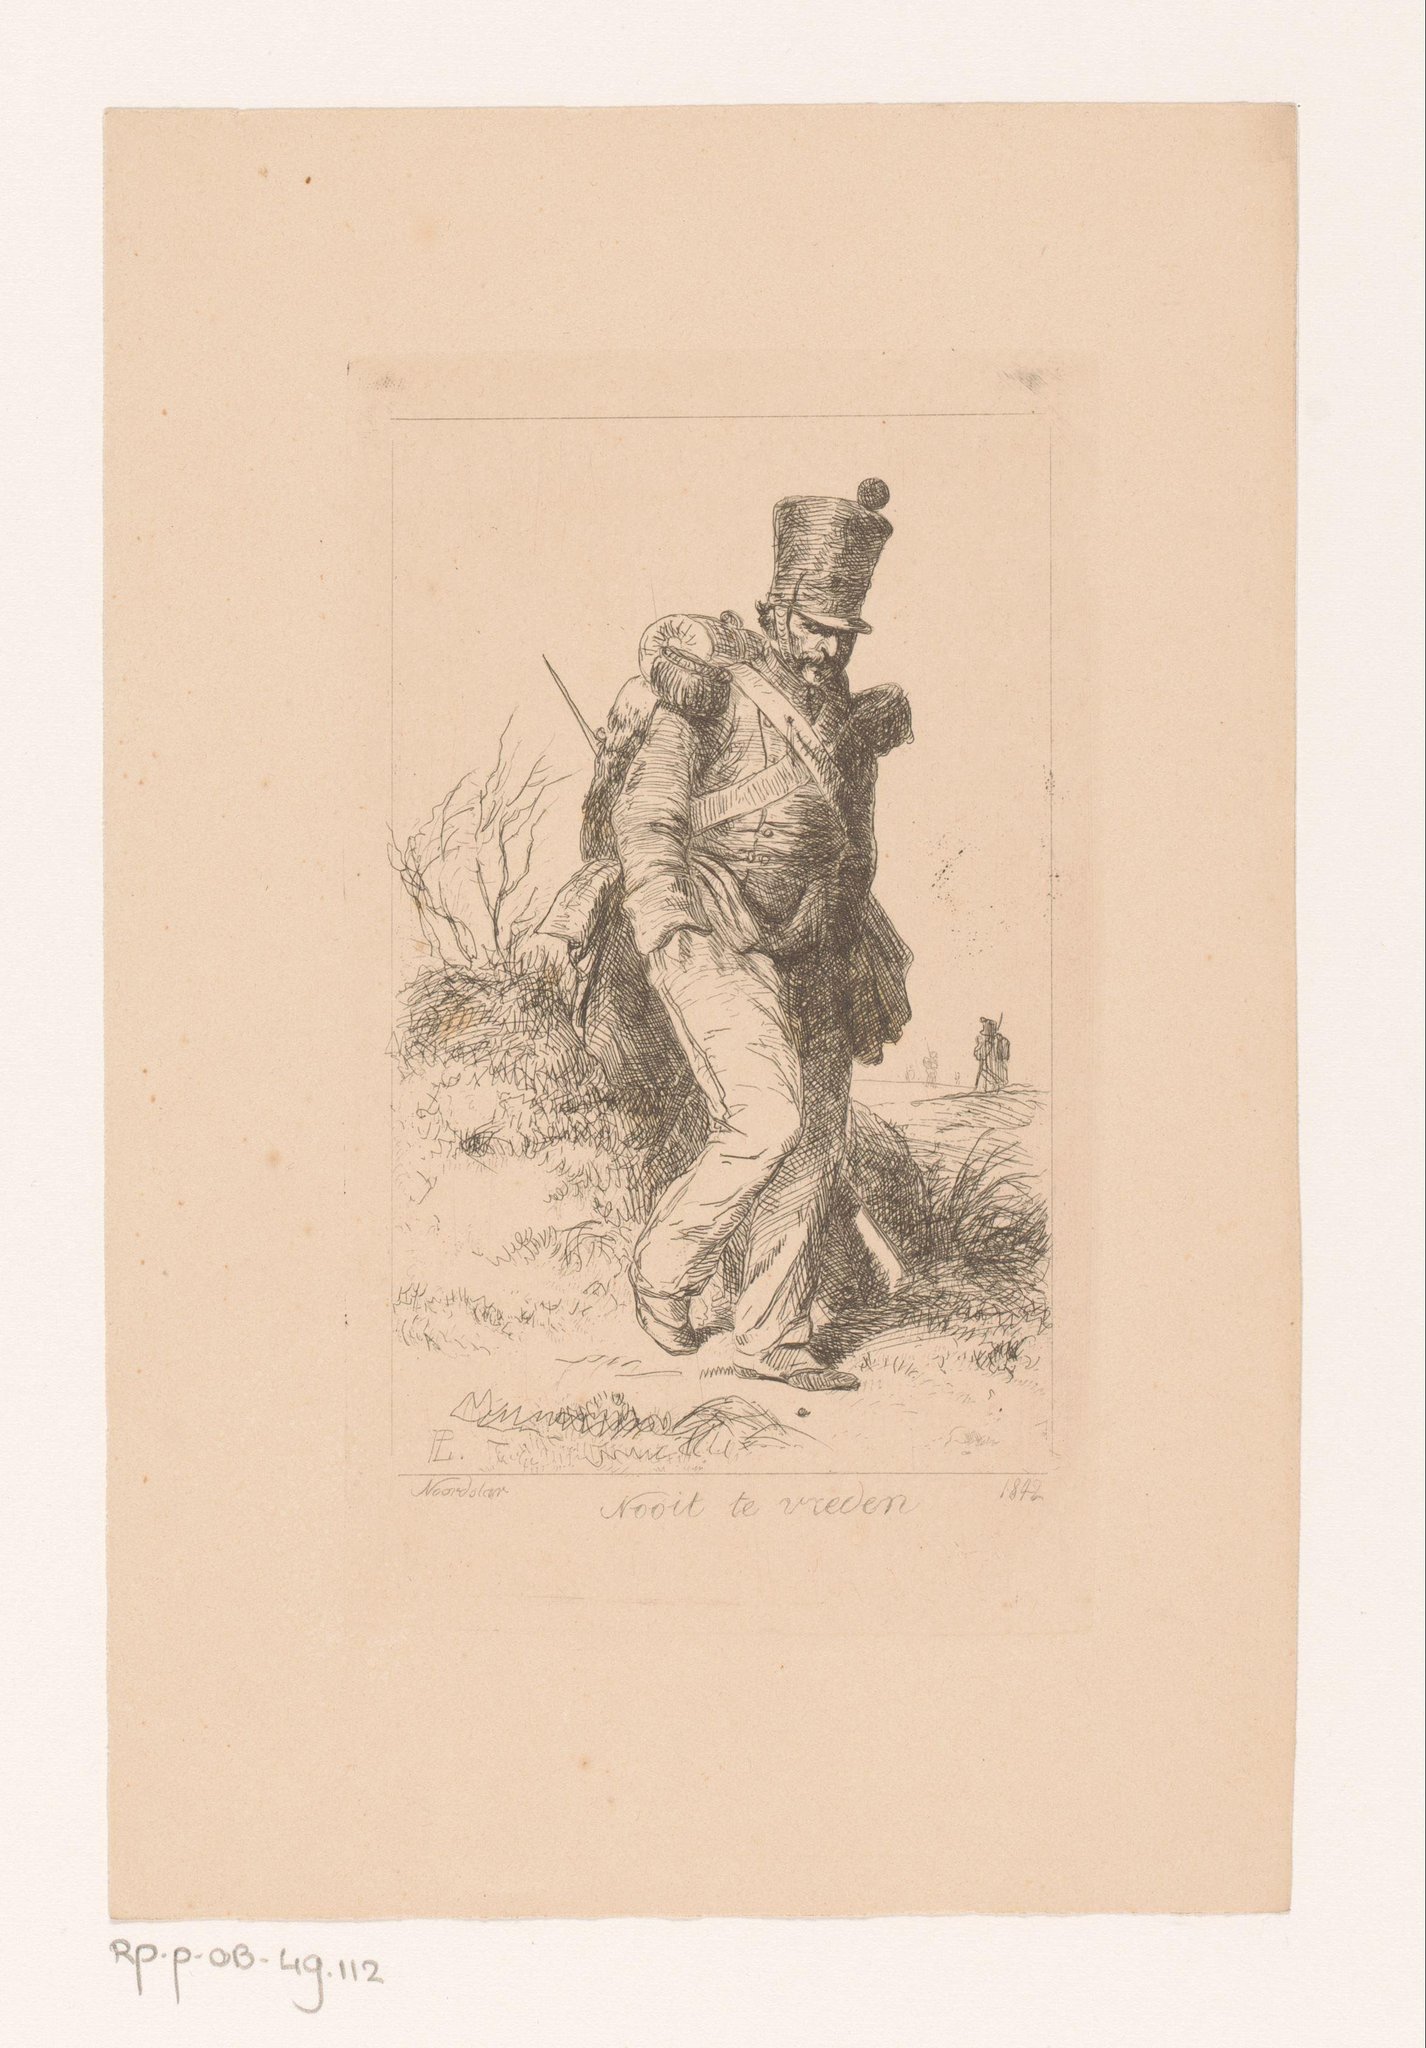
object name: book illustration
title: Soldaat stampt op de grond om zijn voeten warm te houden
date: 1842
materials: paper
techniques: etching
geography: antwerp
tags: guard duty, keeping sentry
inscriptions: collector's mark: Lugt 2228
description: Prent uit: De Noordstar 3, 1e deel (1842).